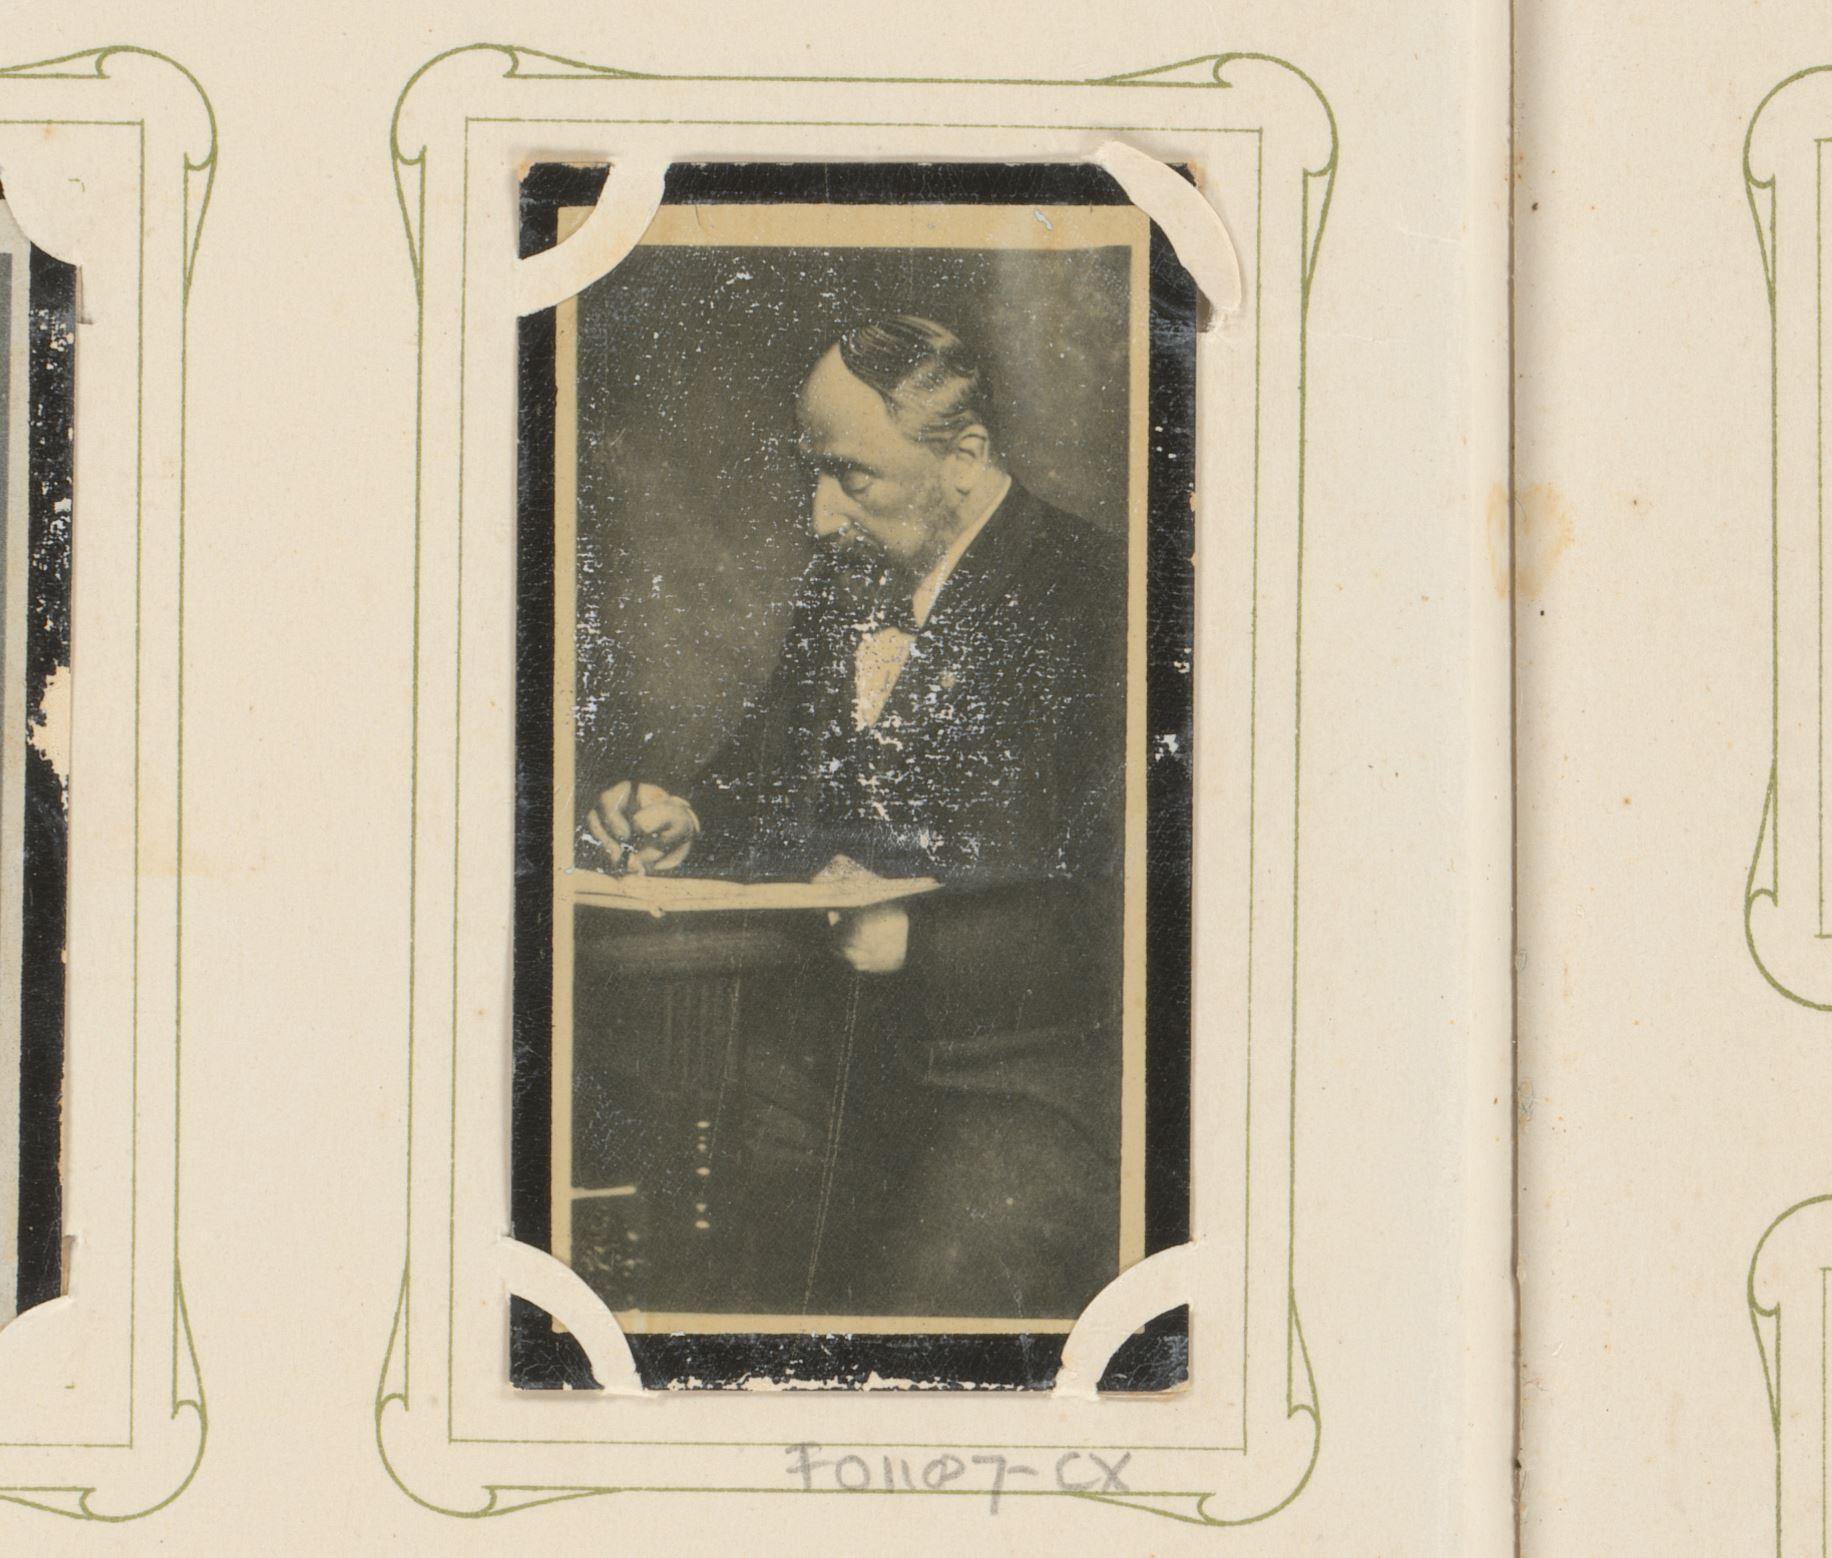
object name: album leaf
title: Portret van Hendrik Willem Mesdag, schrijvend aan een tafel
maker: Anonymous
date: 1905-1906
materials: paper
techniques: photograph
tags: the hague, painter, draughtsman, hendrik willem mesdag, historical persons, portrait, self-portrait of painter, writing and letters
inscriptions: inscription: ‘No. 3./ Mesdag.’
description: Deze prent maakt deel uit van een album.